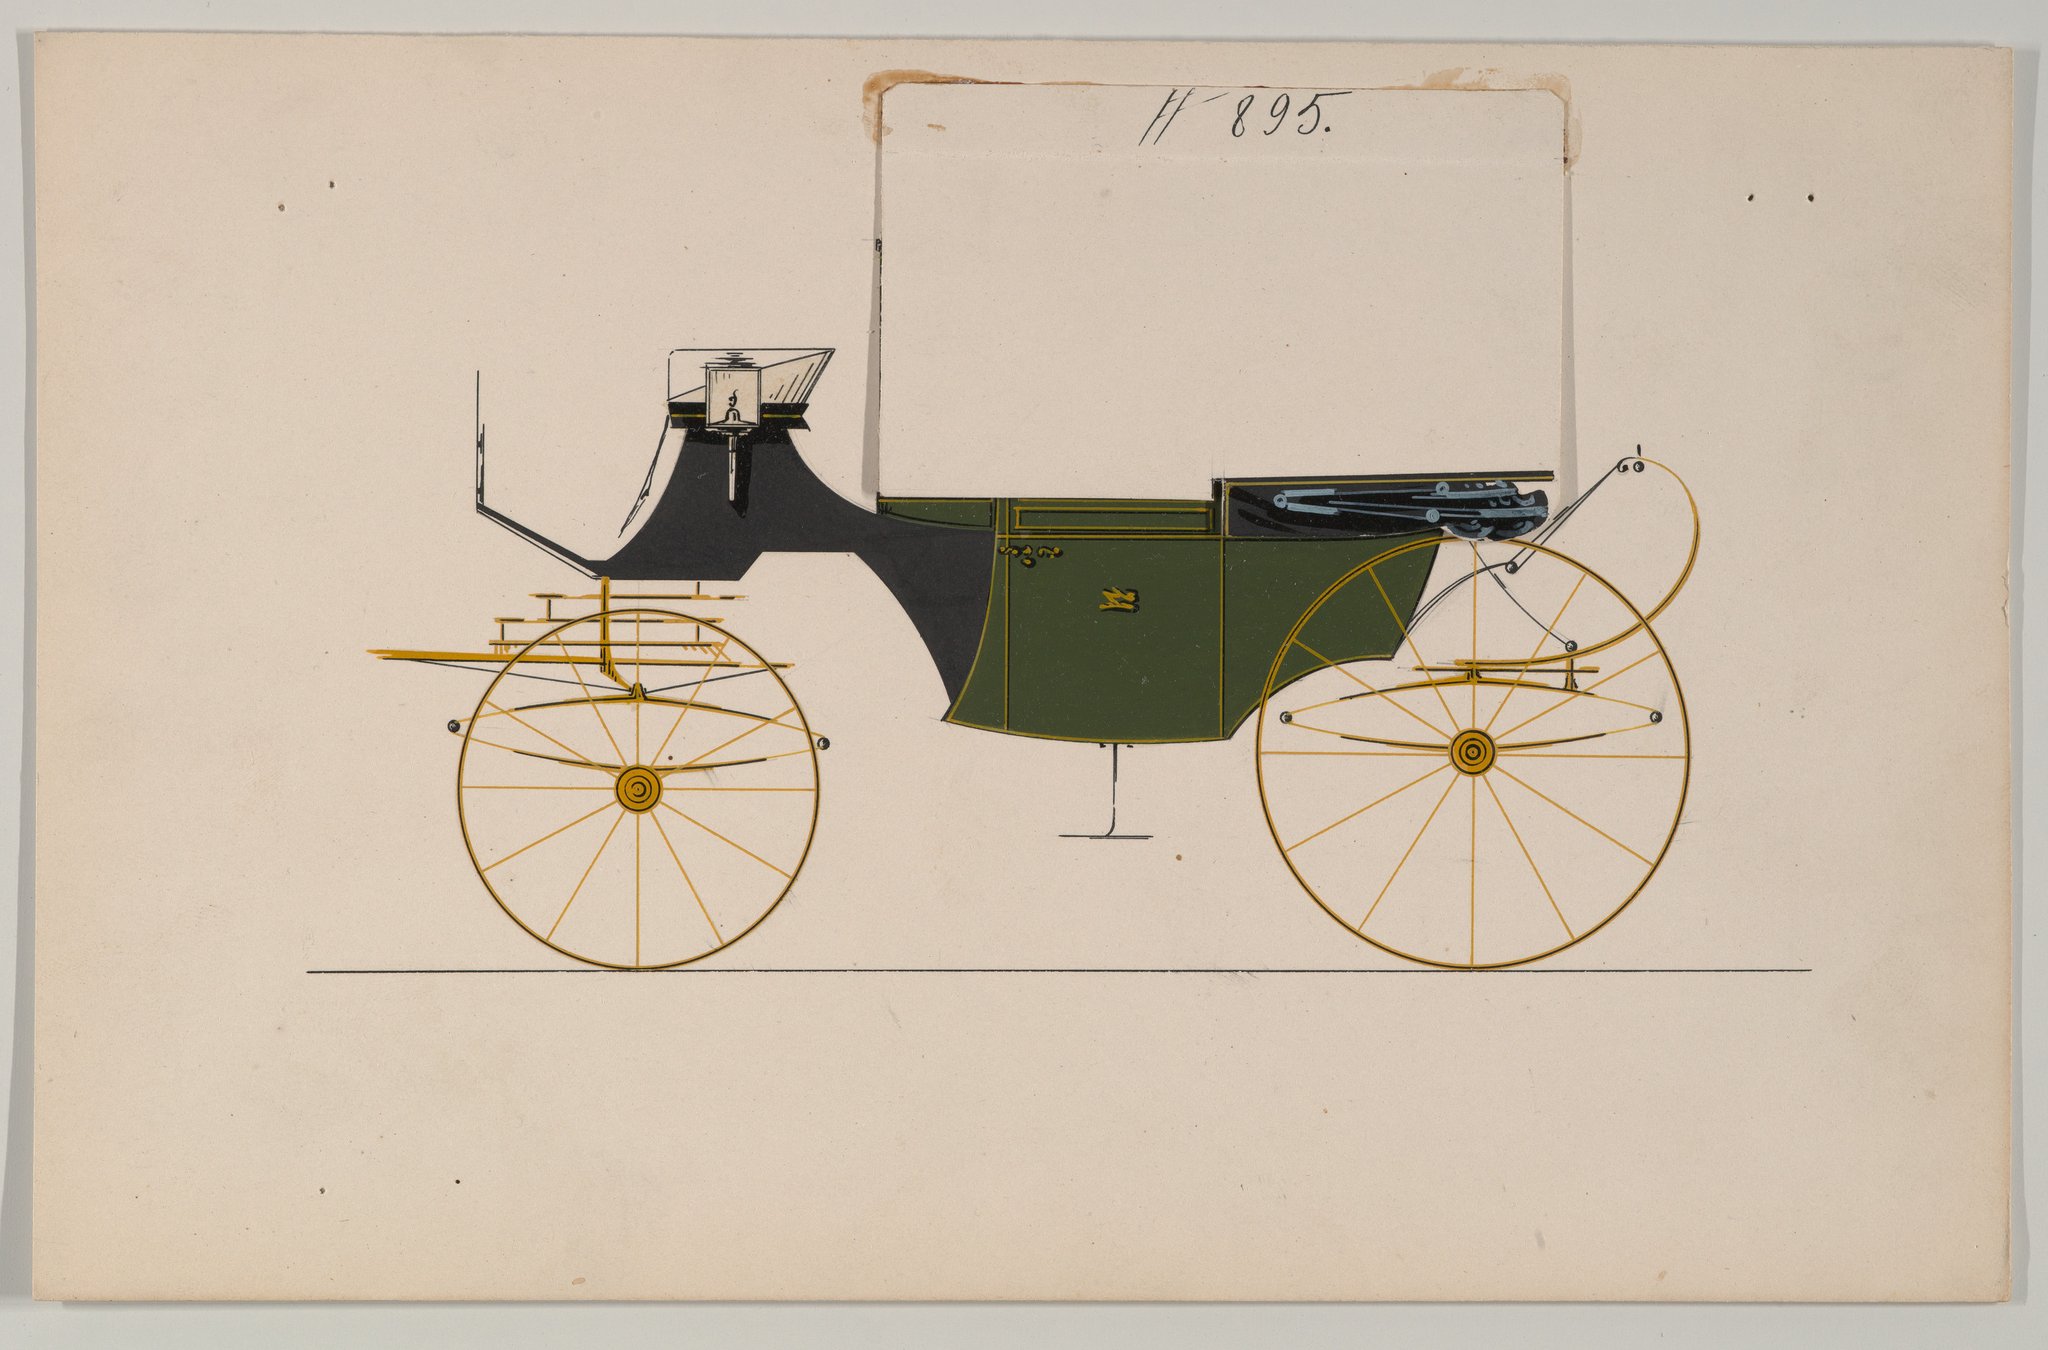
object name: drawing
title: Landaulet #895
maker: brewster & co.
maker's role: manufacturer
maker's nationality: american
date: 1850-1870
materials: gouache, ink, watercolor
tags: carriages